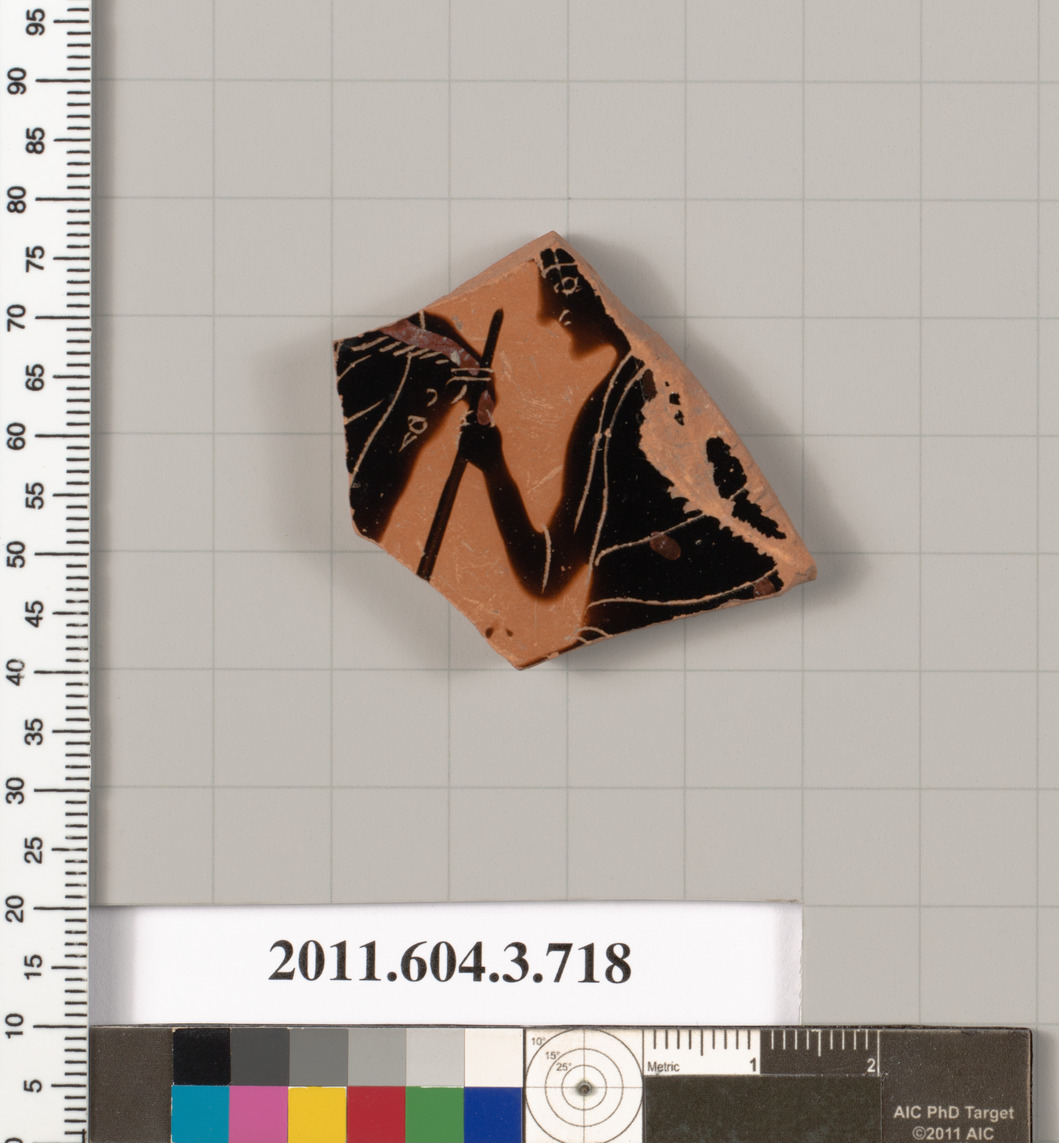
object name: hydria fragment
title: Terracotta hydria: kalpis (water jar)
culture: greek, attic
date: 525-501 BCE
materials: terracotta